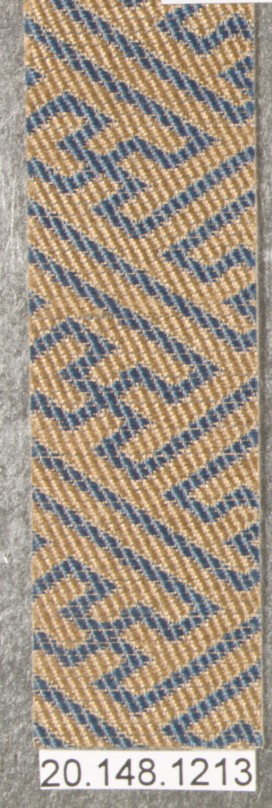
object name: piece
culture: japanese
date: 1801-1900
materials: silk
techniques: compound weave